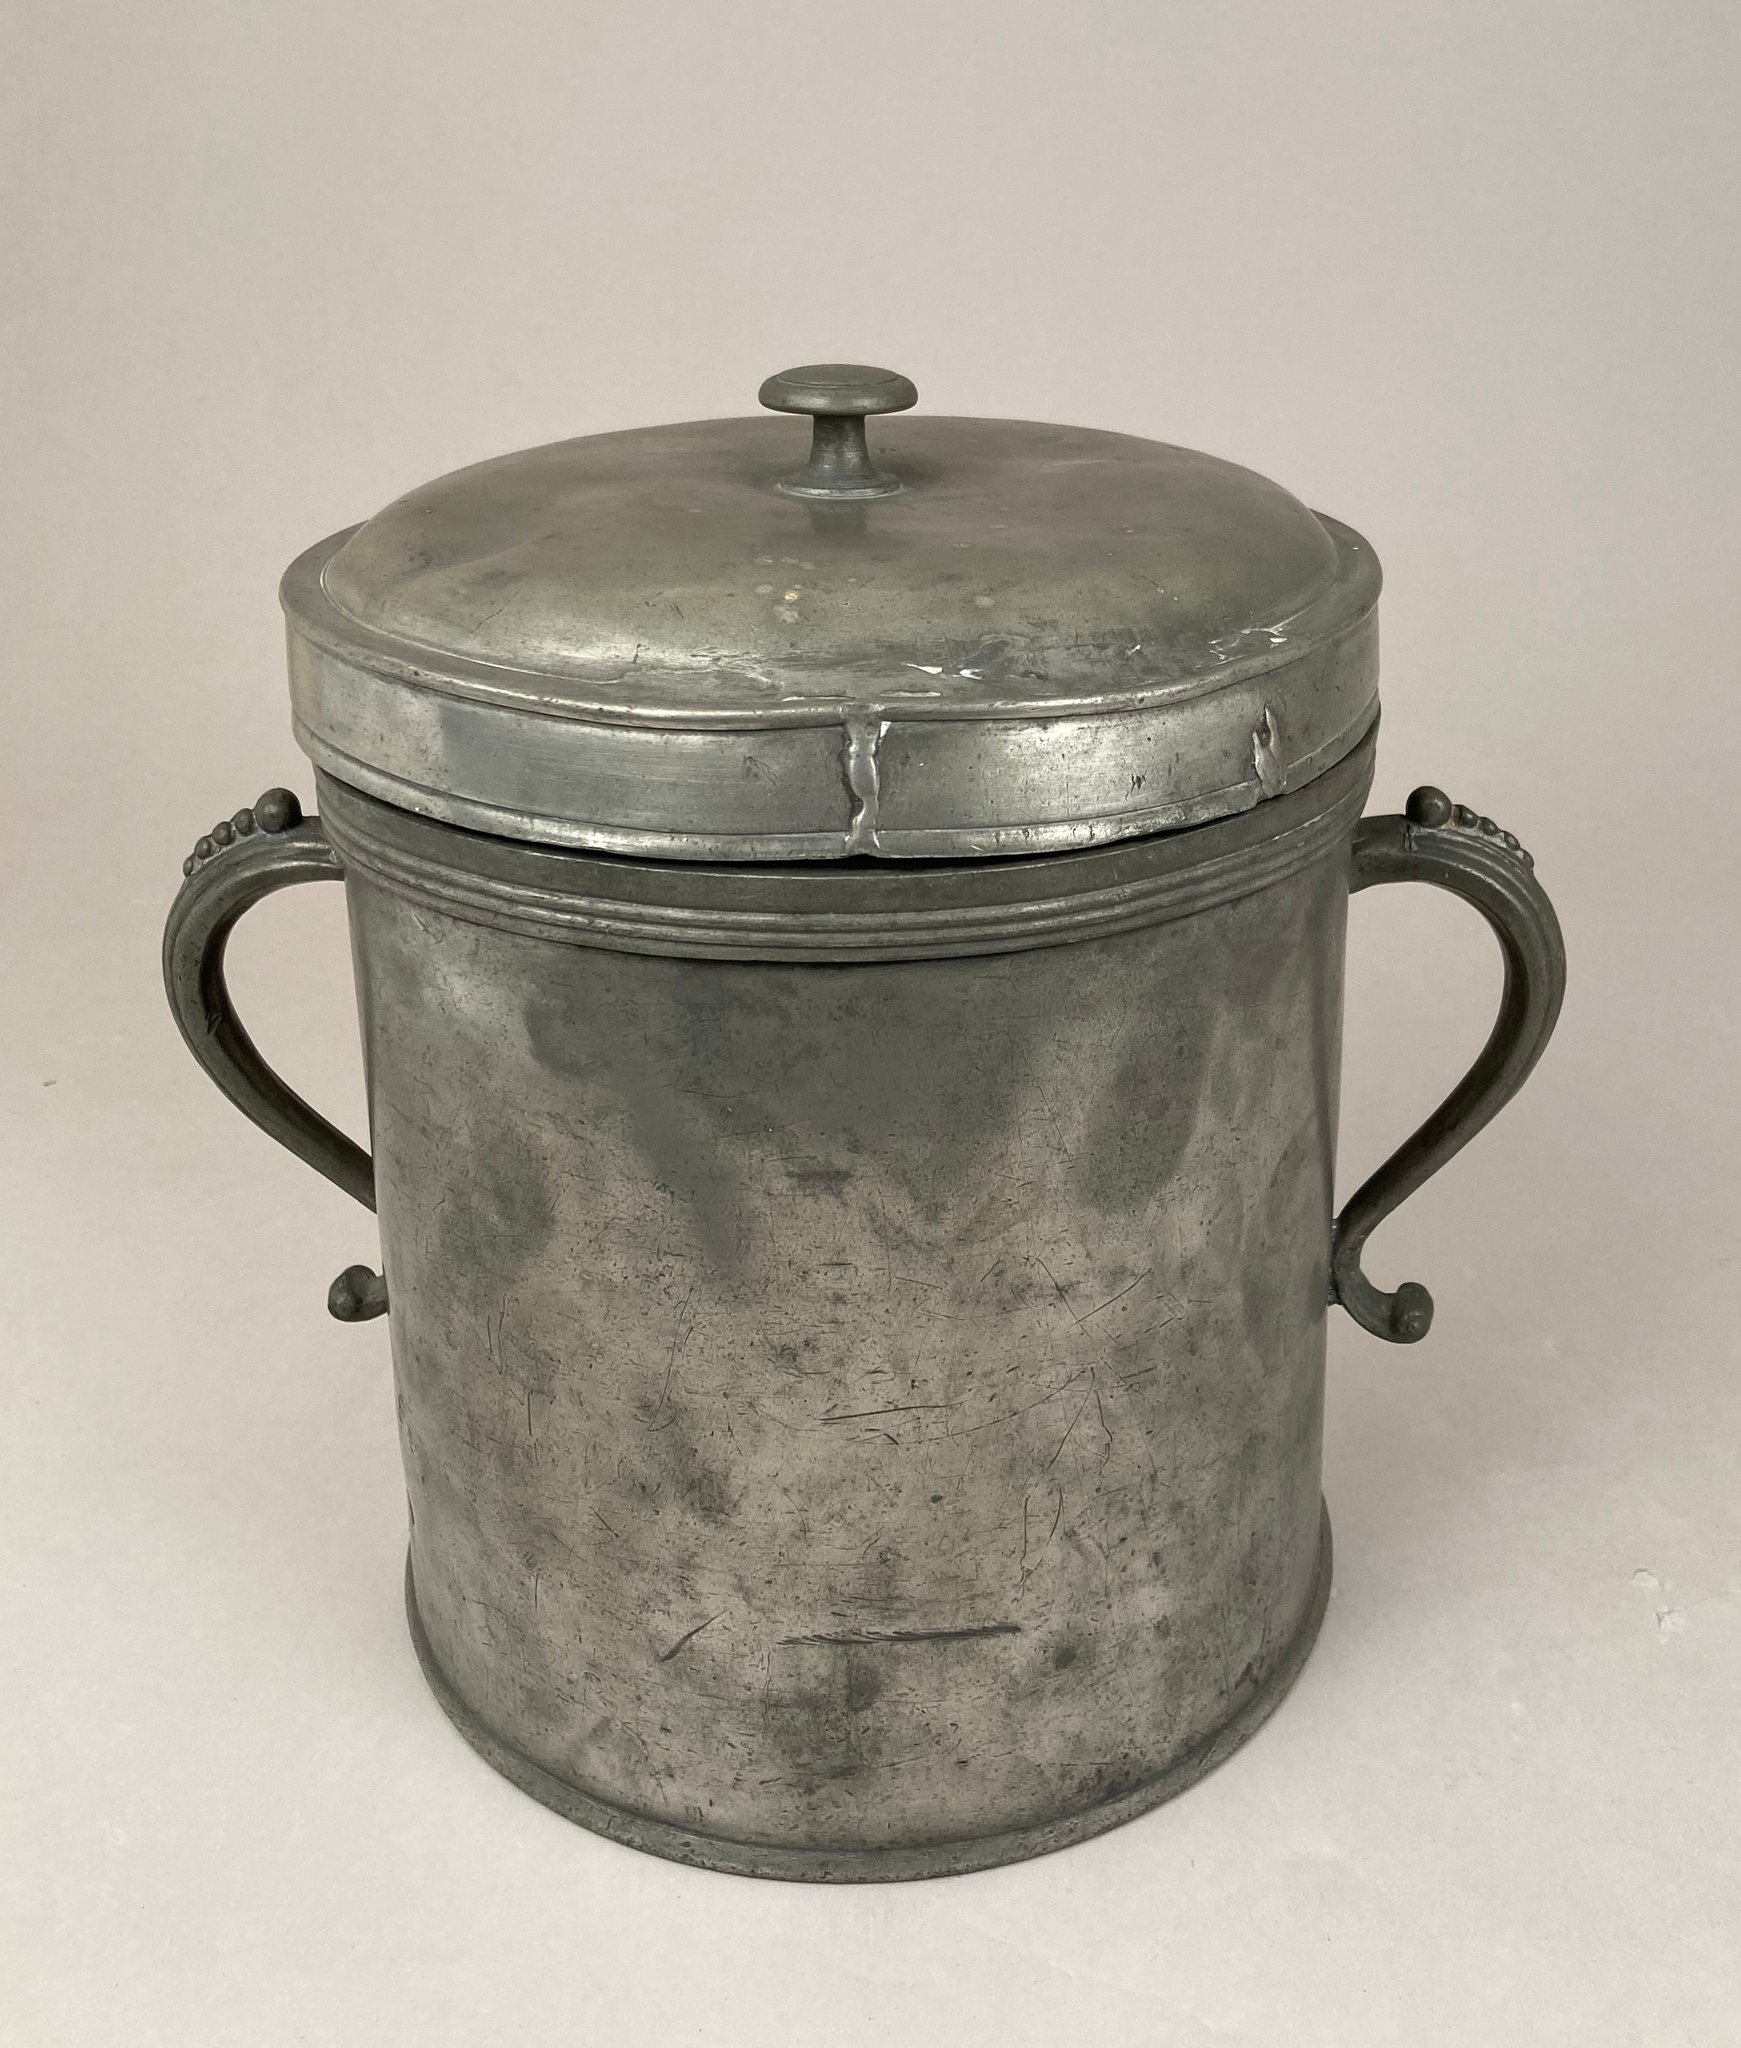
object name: canister with cover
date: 1601-1800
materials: pewter